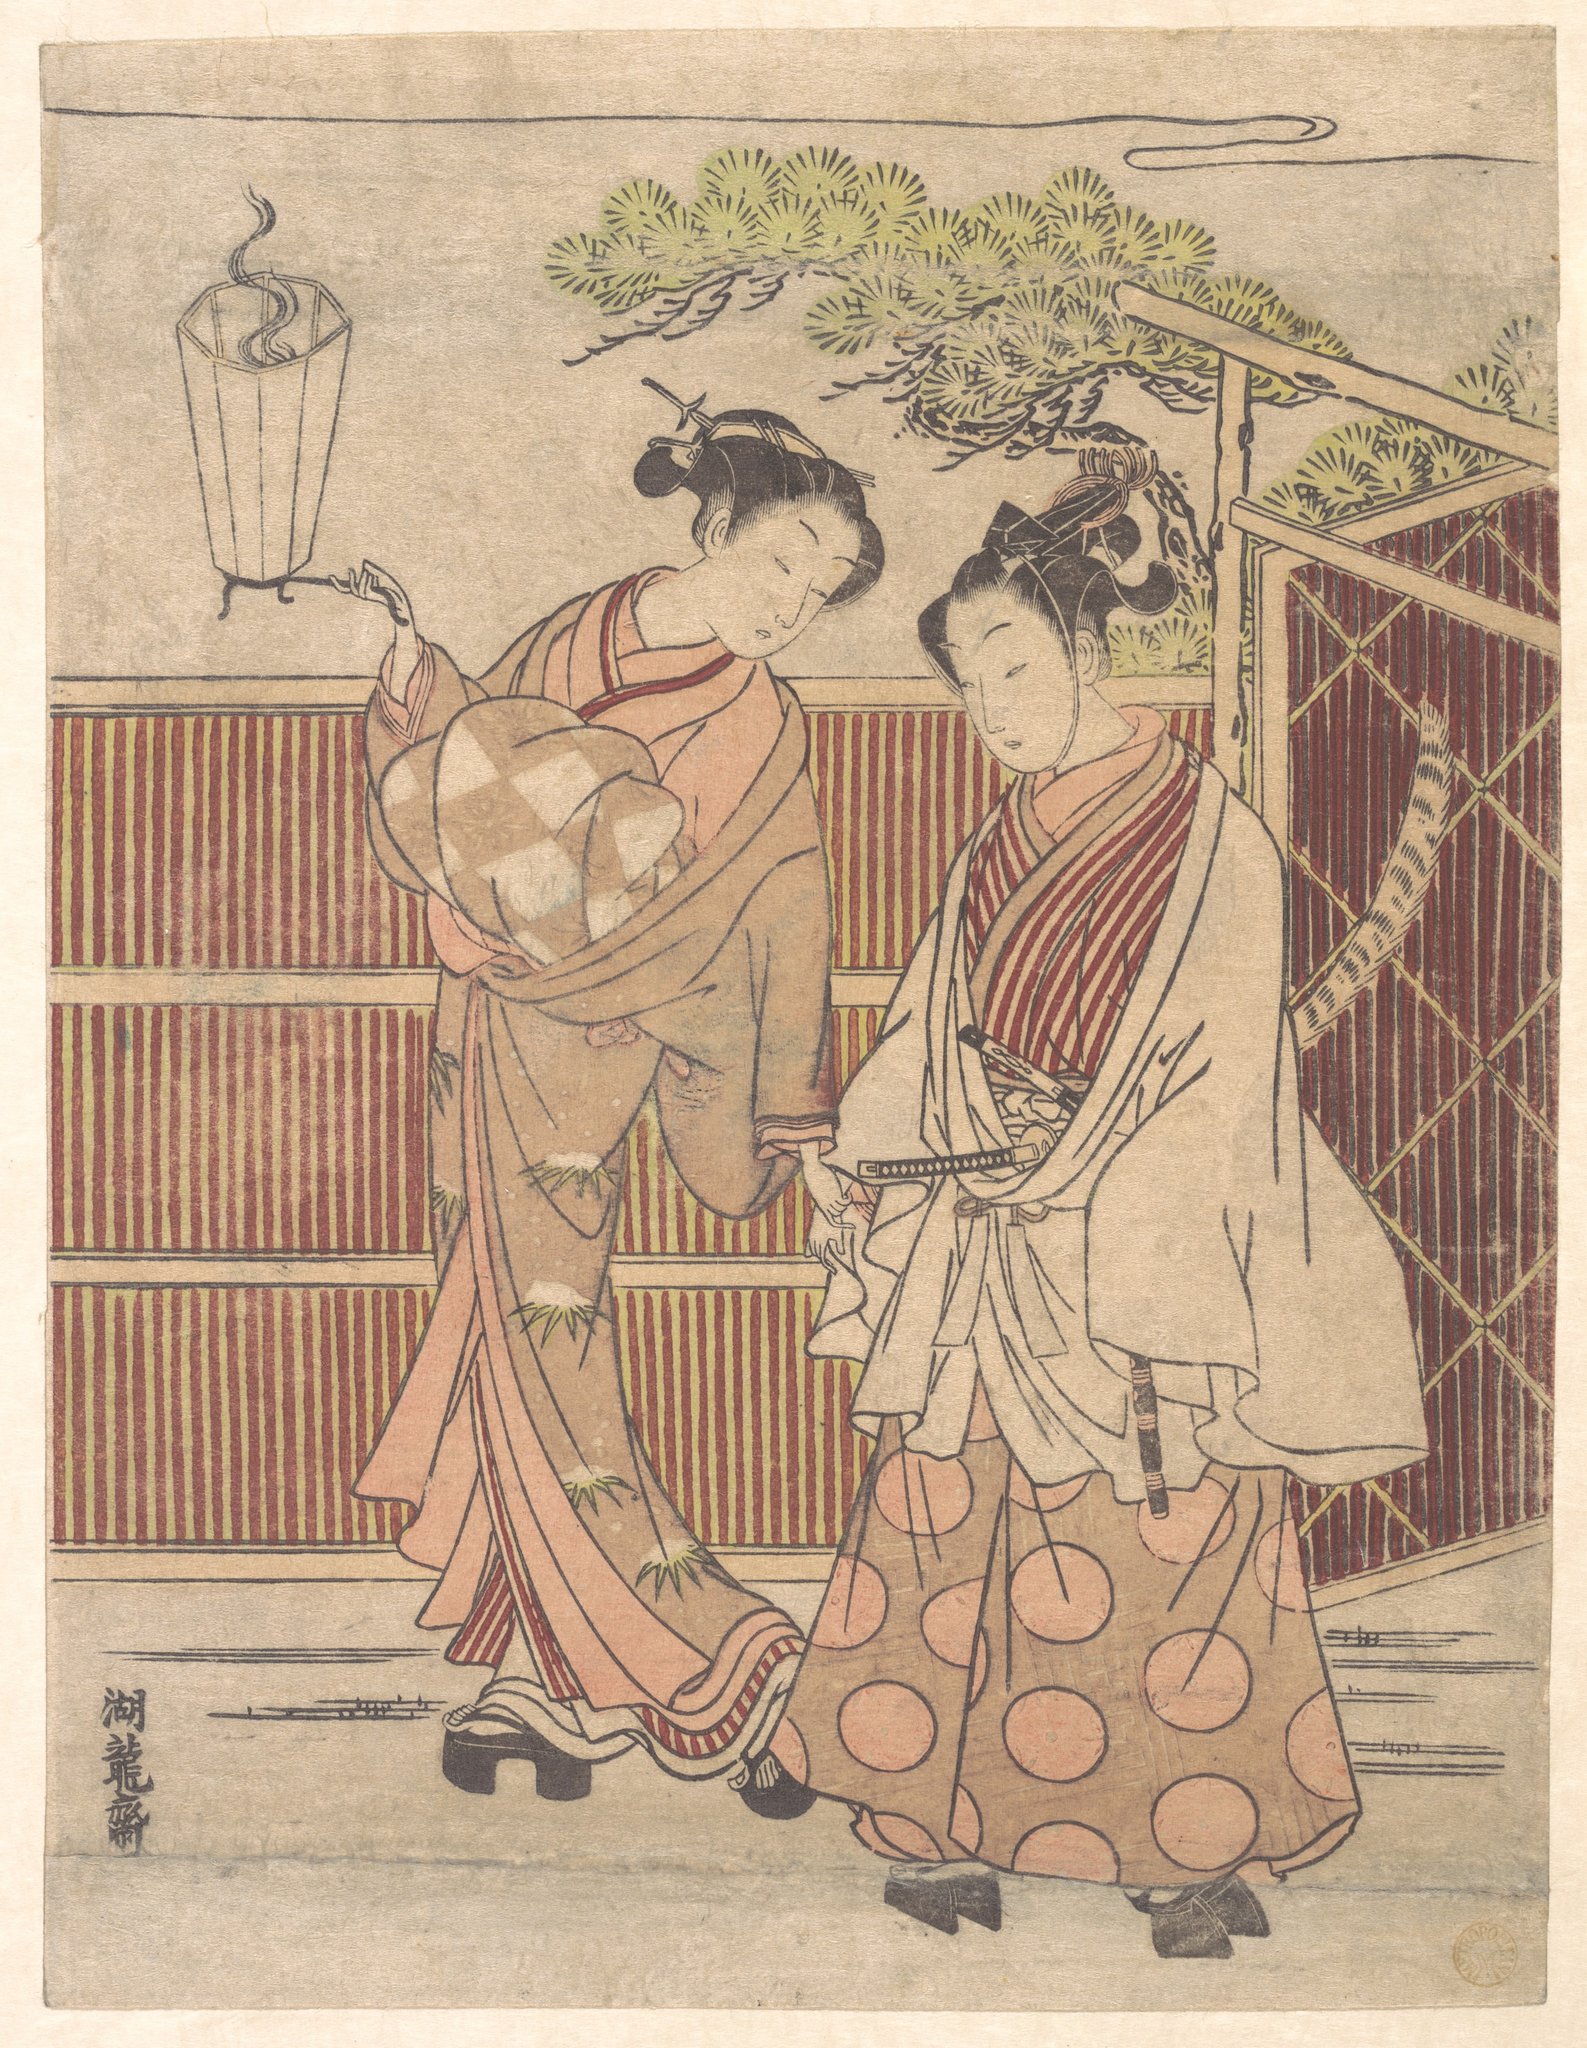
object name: woodblock print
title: Reizei Carrying a Teshoku (Hand Lantern)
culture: japanese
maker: isoda koryūsai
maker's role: artist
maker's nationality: japanese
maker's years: 1735-1790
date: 1769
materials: ink, paper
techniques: woodblock print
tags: women